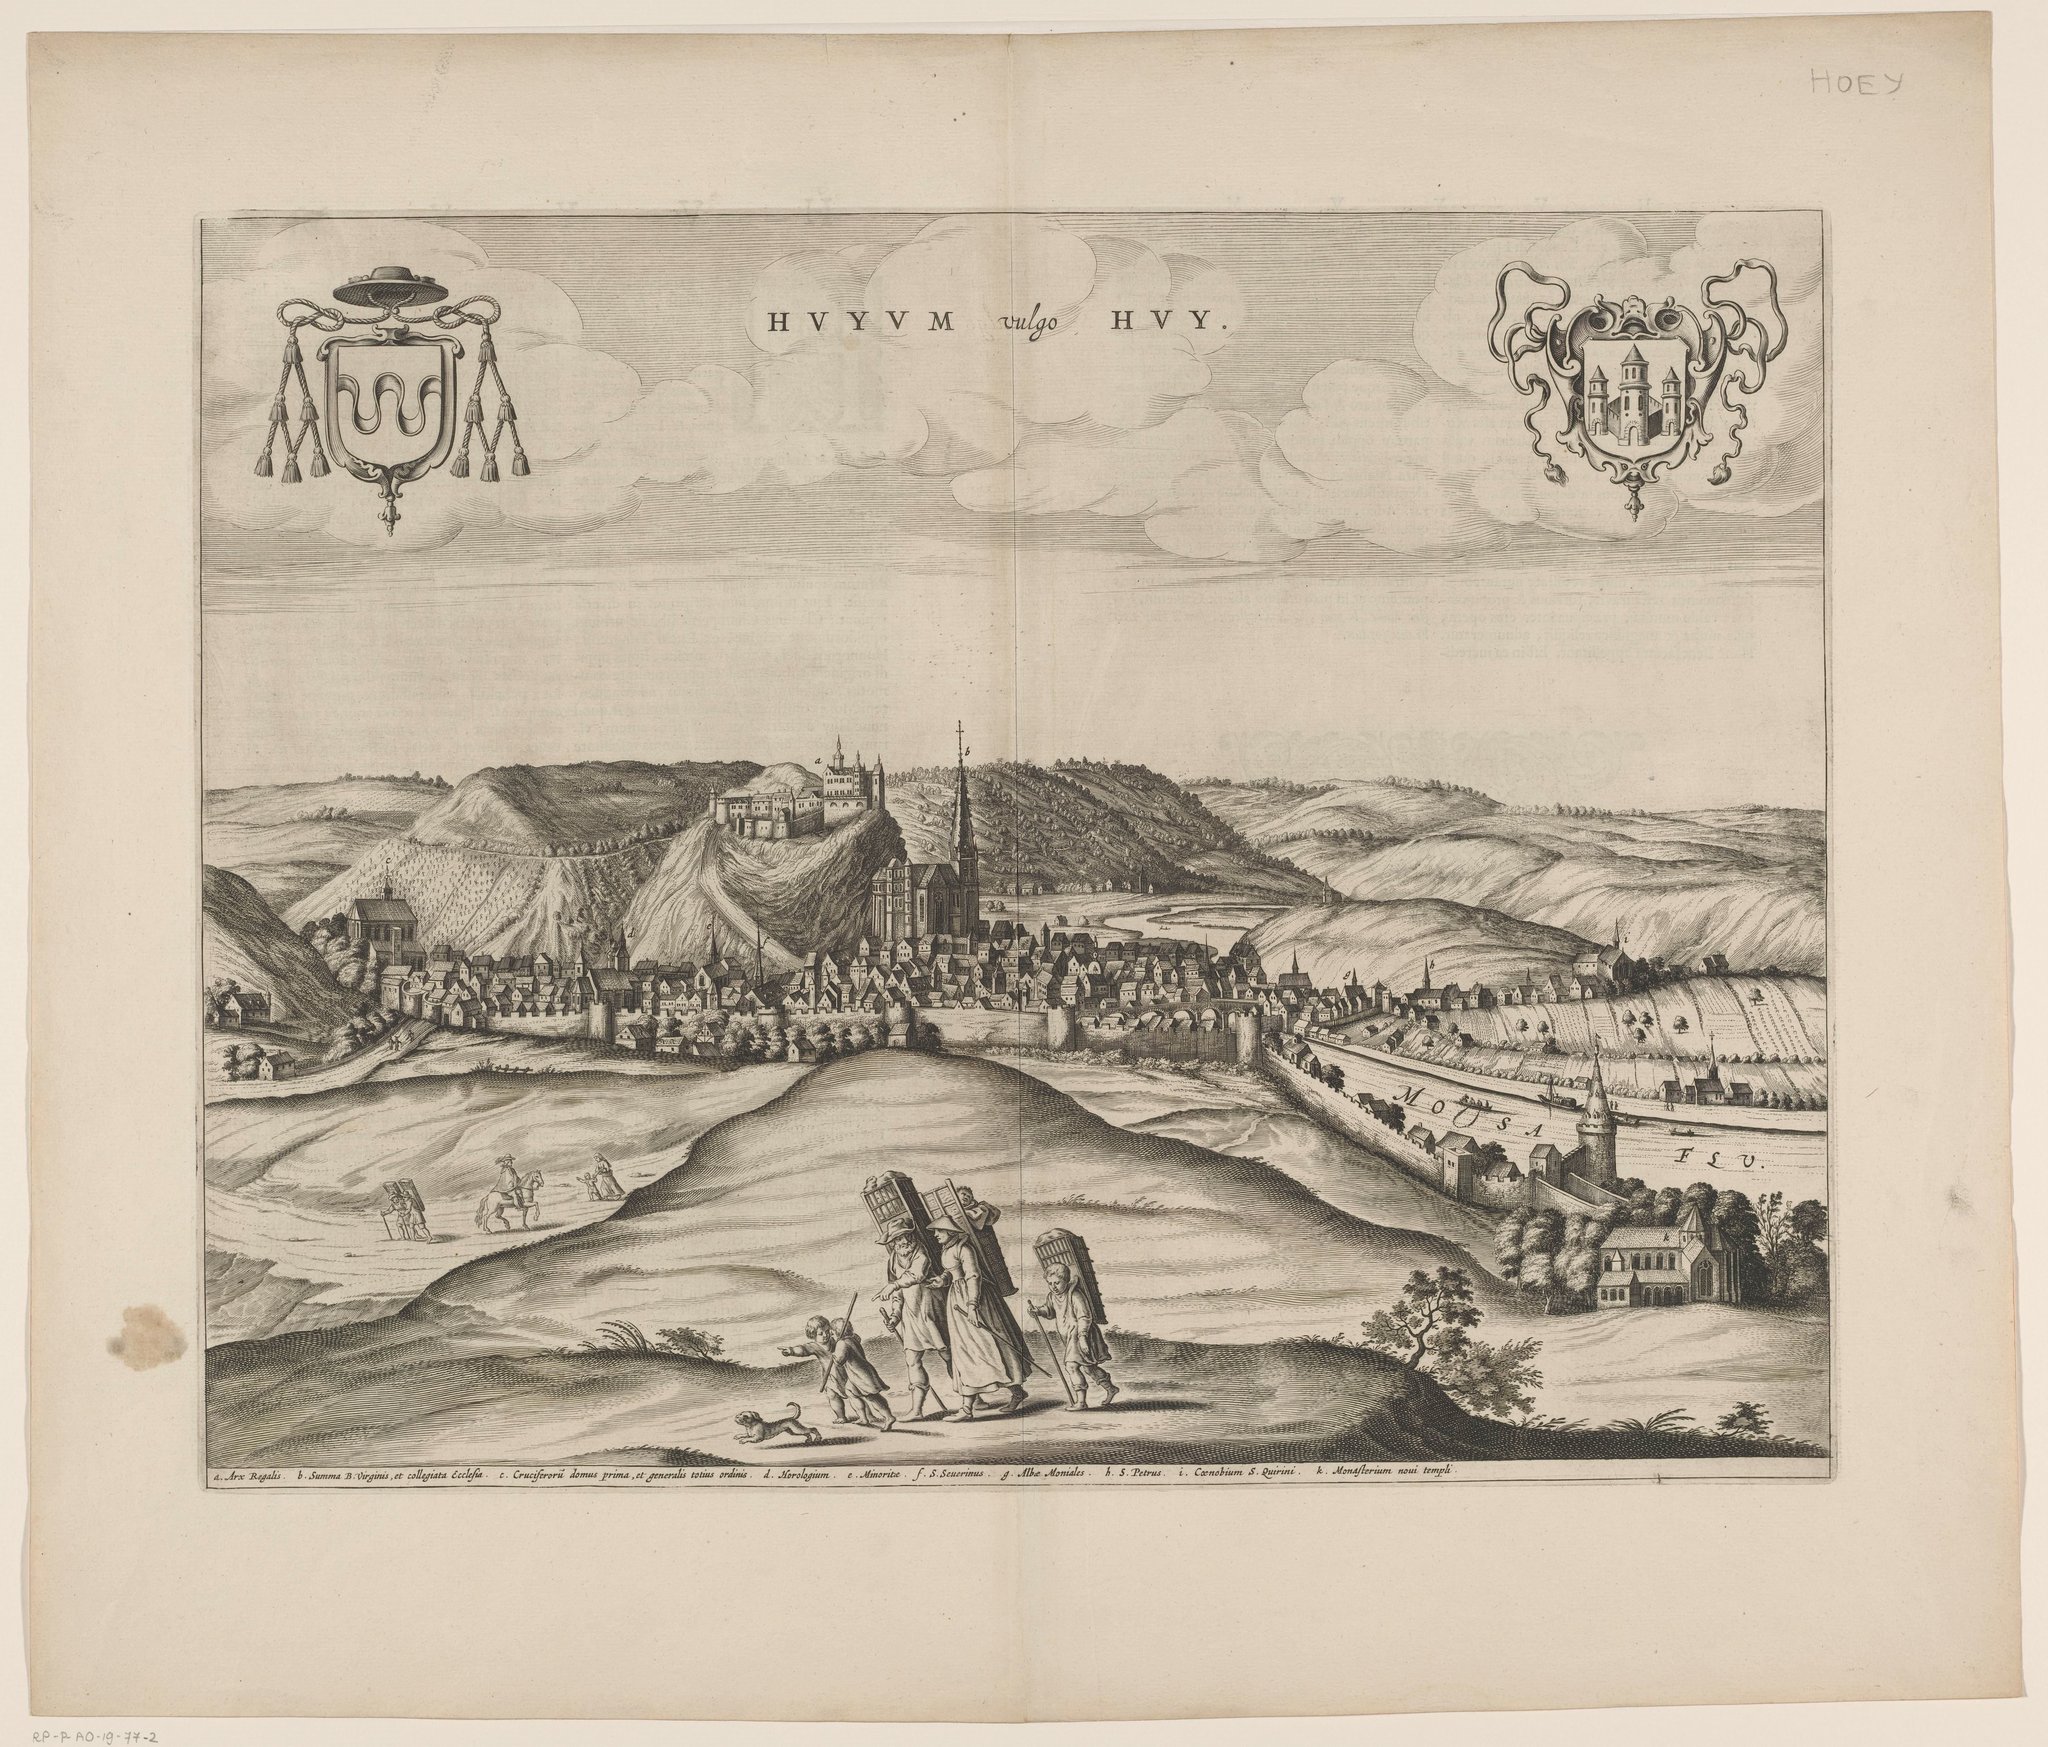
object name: print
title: Gezicht op Hoei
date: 1652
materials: paper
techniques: engraving, etching, letterpress printing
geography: amsterdam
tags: coat of arms (as symbol of the state, etc.) (+ city; municipal), prospect of city, town panorama, silhouette of city, armorial bearing, heraldry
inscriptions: collector's mark: Lugt 2228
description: Gezicht op Hoei. Onder een legenda a-k. Linksboven het wapen van de Luikse prins-bisschop Gerard van Groesbeek, rechtsboven het wapen van Hoei. Met Latijnse tekst op verso.